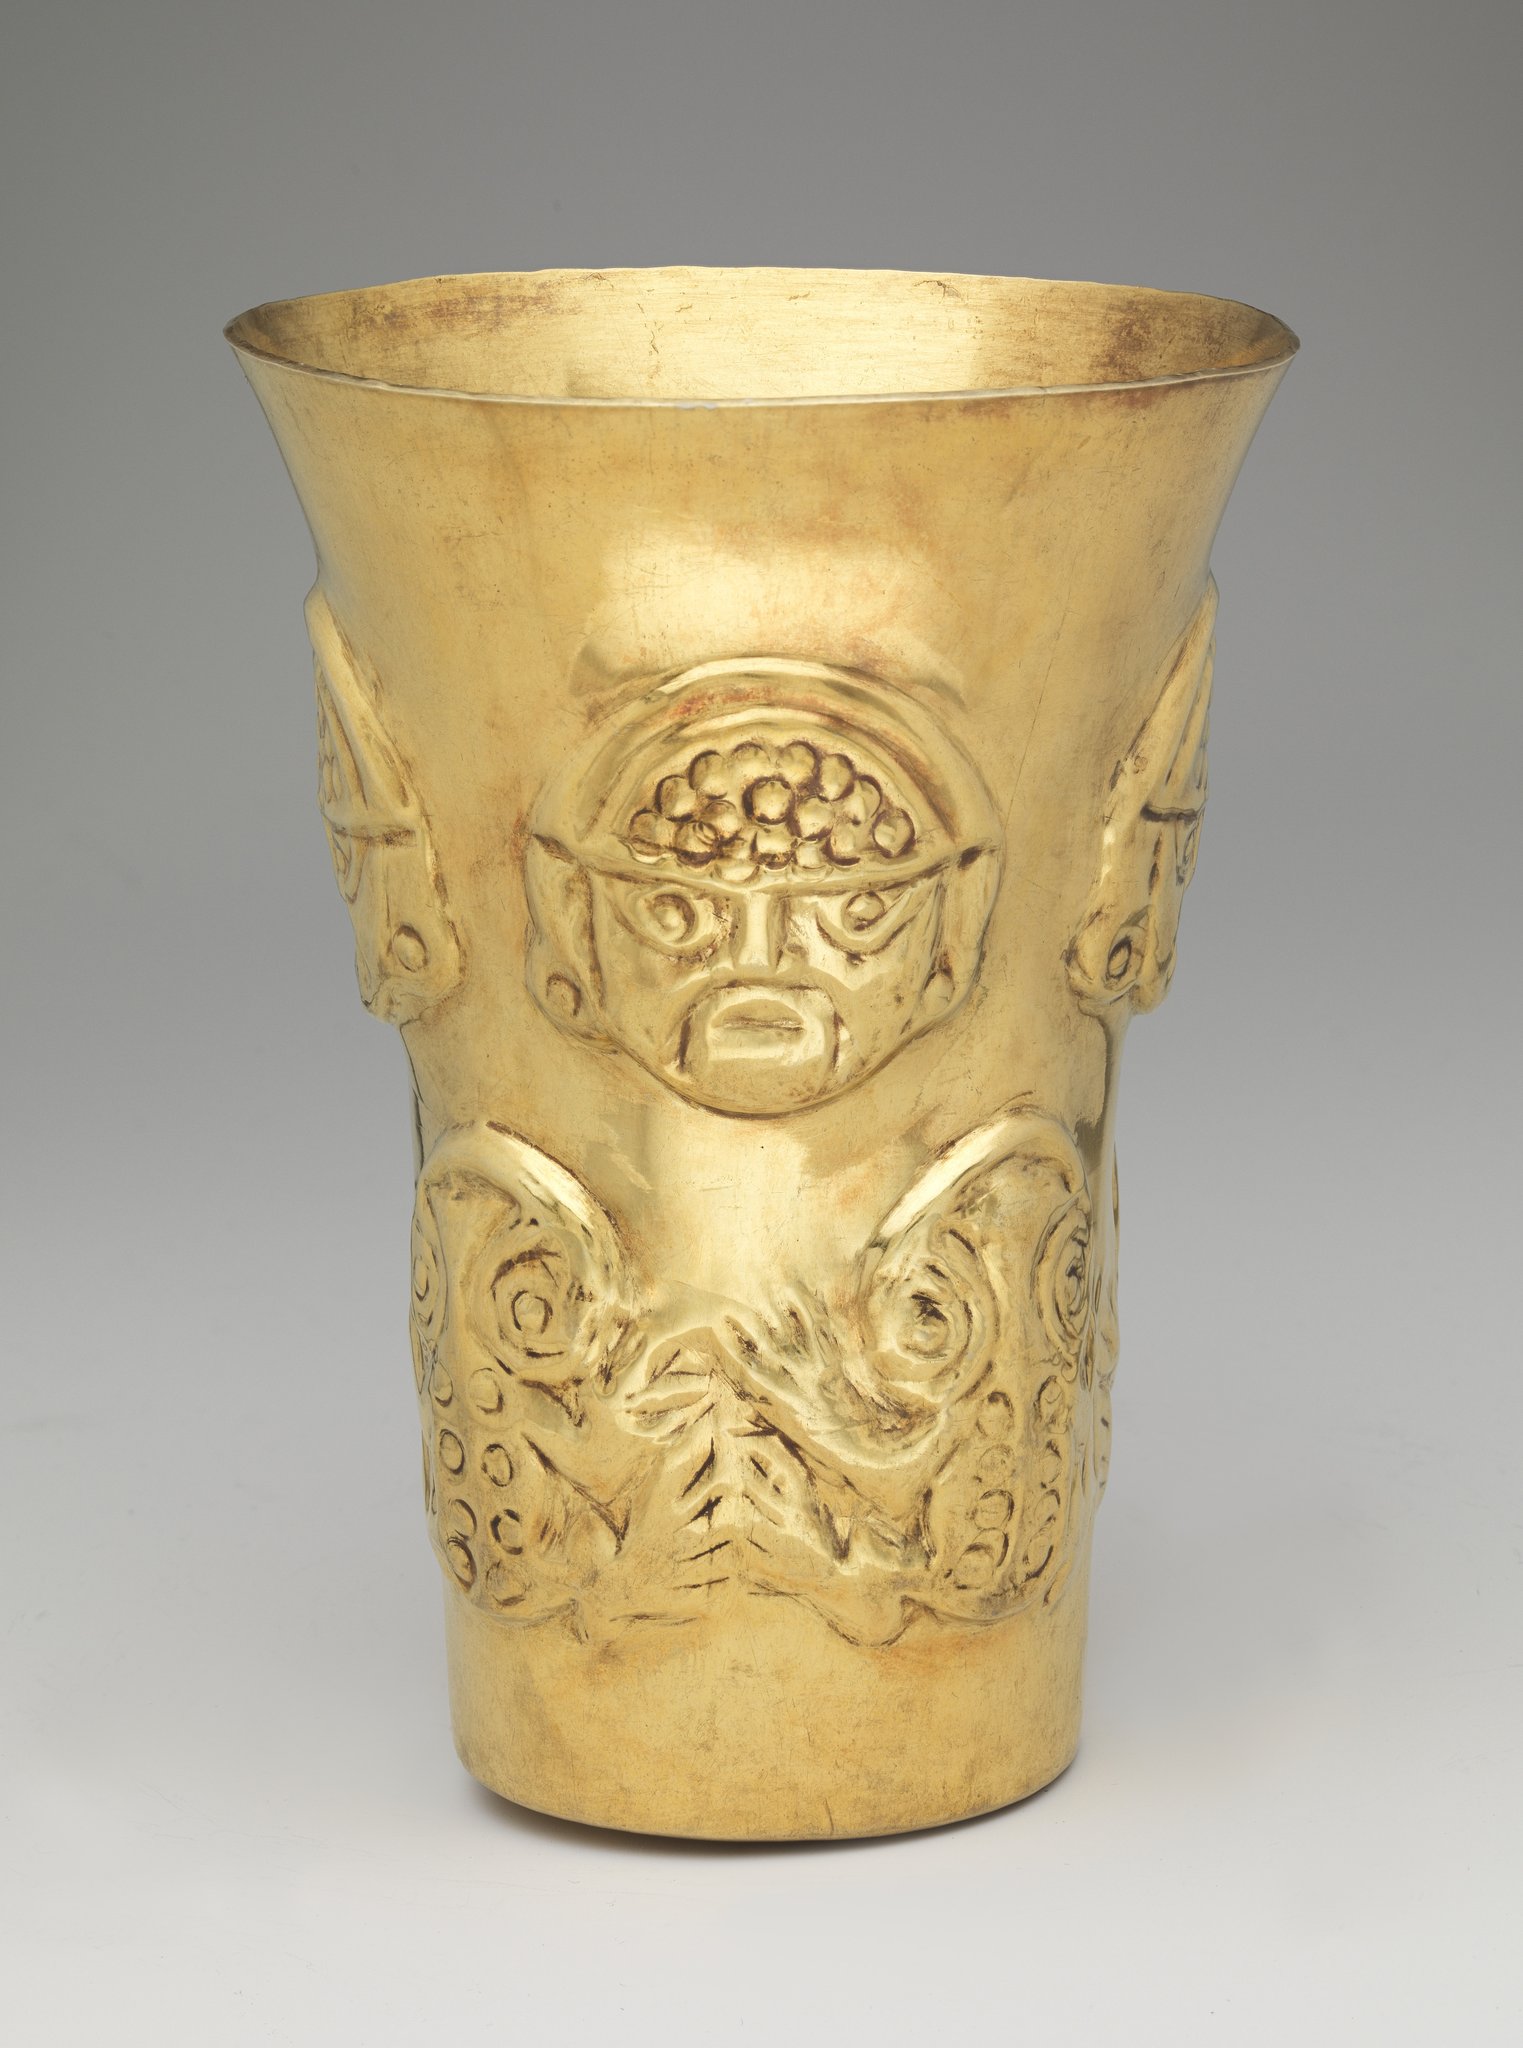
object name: beaker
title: Beaker with heads and toads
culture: lambayeque, sicán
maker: lambayeque (sicán) artist(s)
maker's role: artist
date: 900-1100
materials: gold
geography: peru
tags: faces,frogs